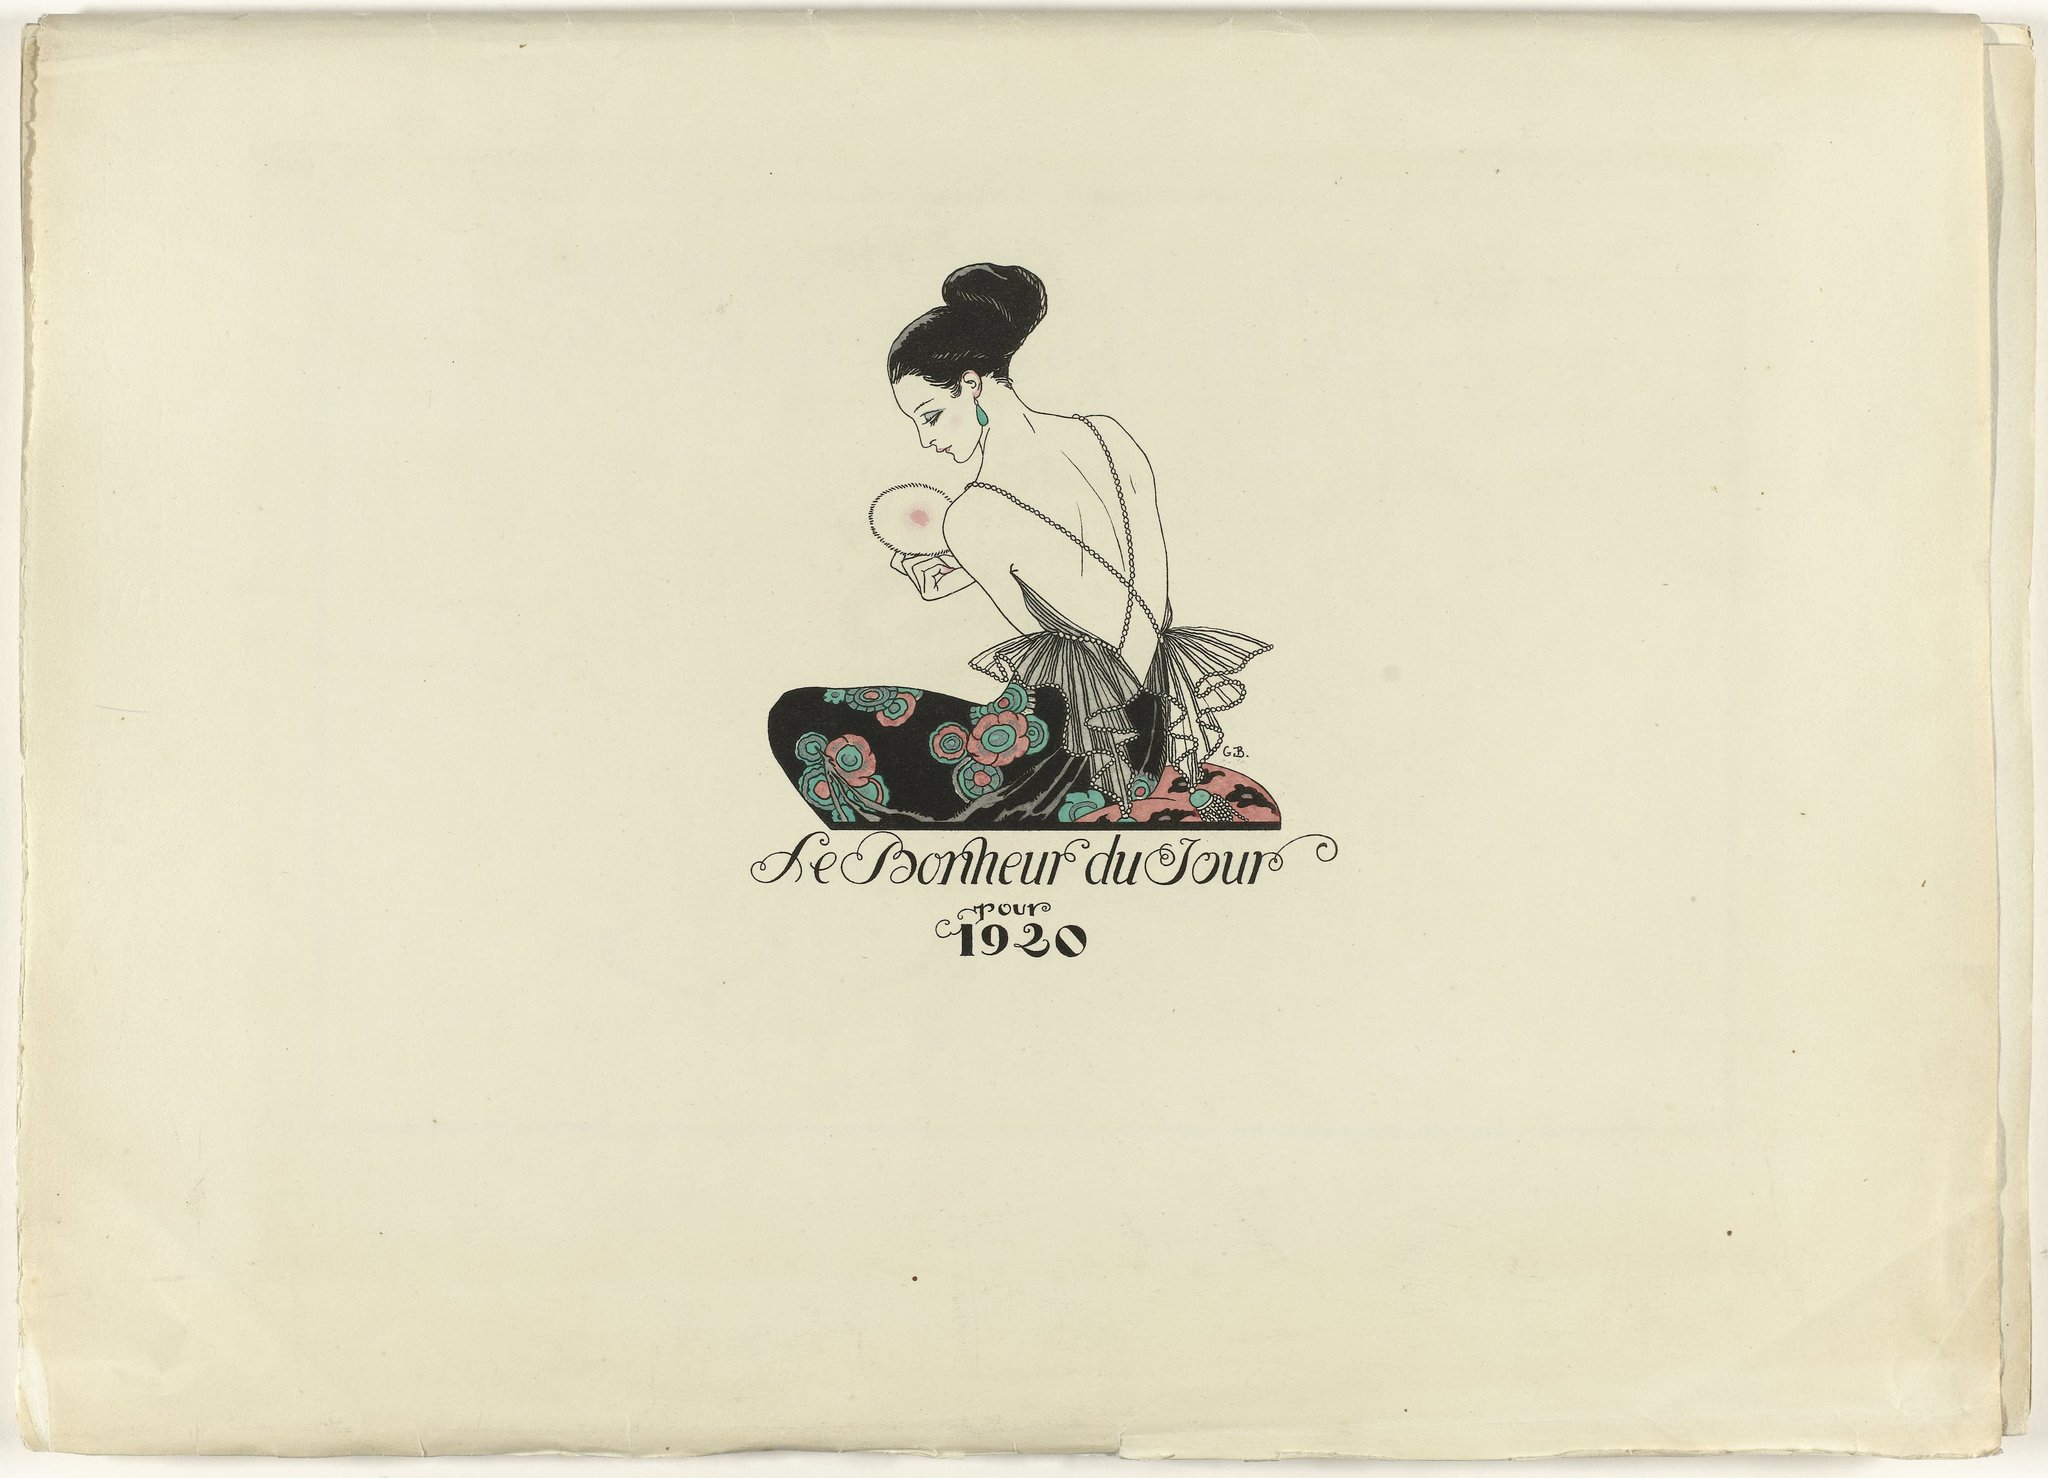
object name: fashion print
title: Le Bonheur du Jour ou Les Graces à la Mode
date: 1920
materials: paper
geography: paris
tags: fashion plates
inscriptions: date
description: Serie van 18 modeprenten, met titelblad en inhoudsopgave in omslag. Tekst en tekeningen van George Barbier.